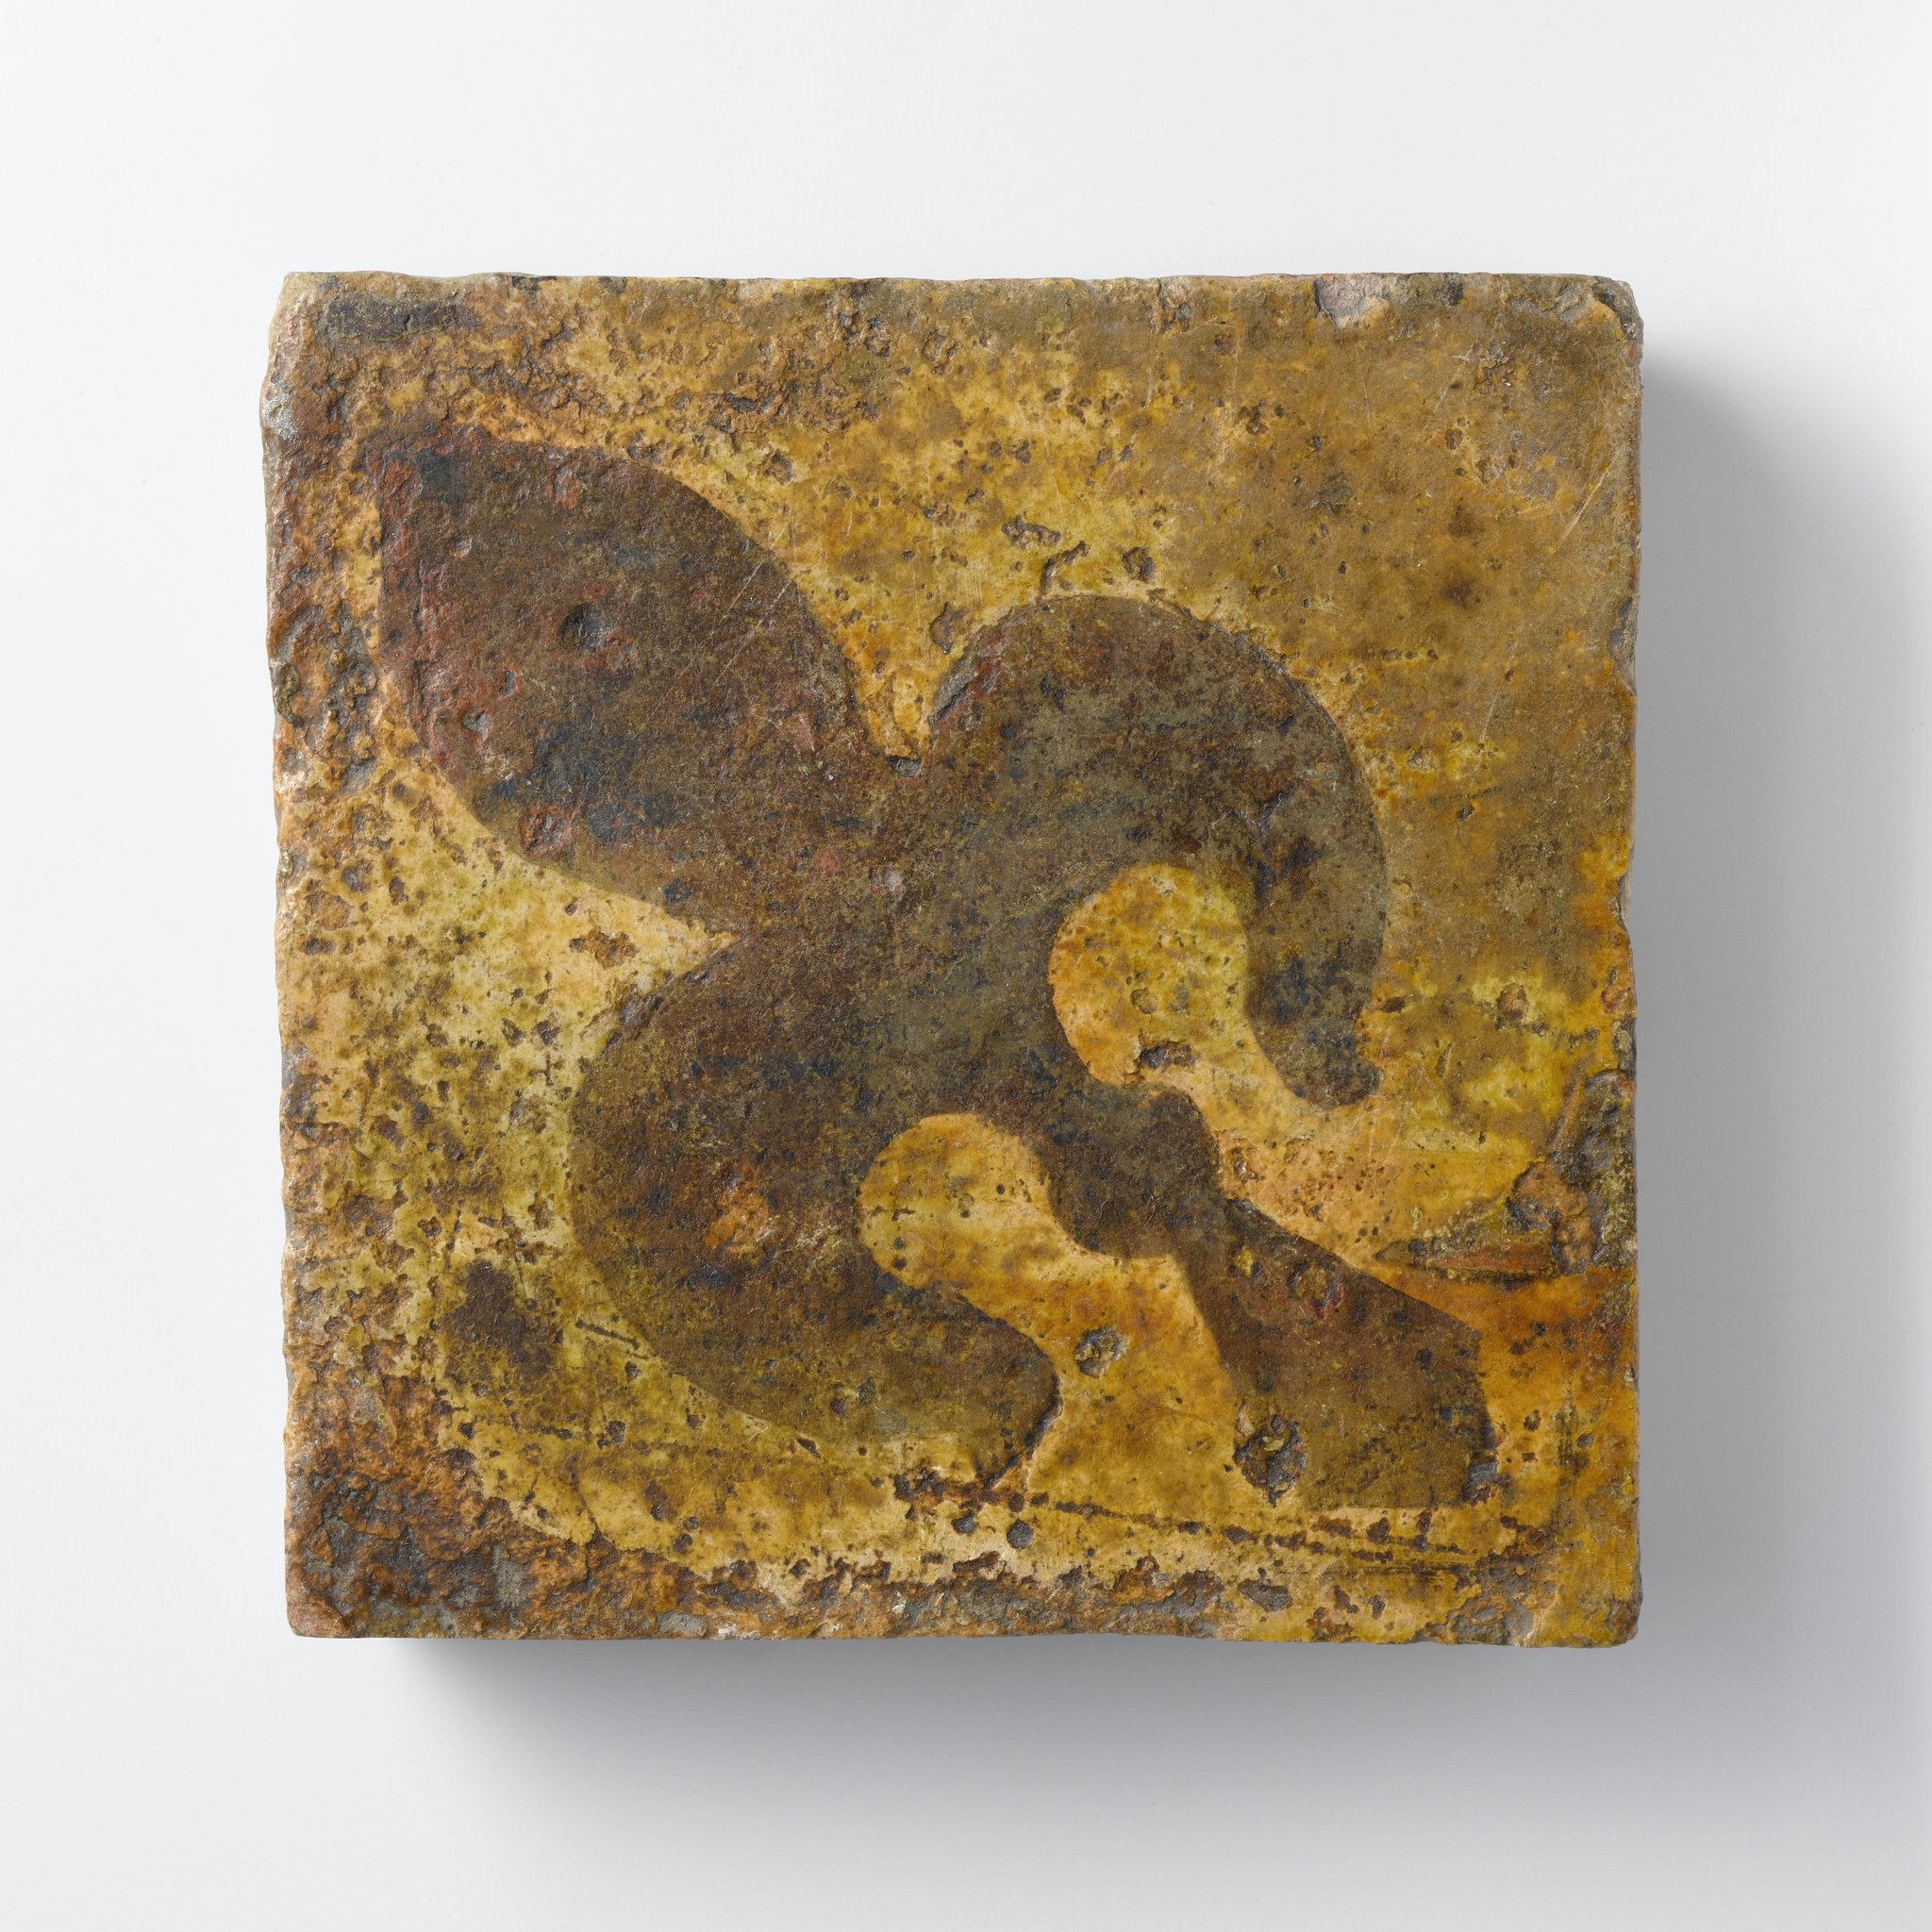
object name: tile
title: Vloertegel versierd met een Franse lelie (bruin)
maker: Anonymous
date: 1299-1499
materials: earthenware, glaze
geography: france